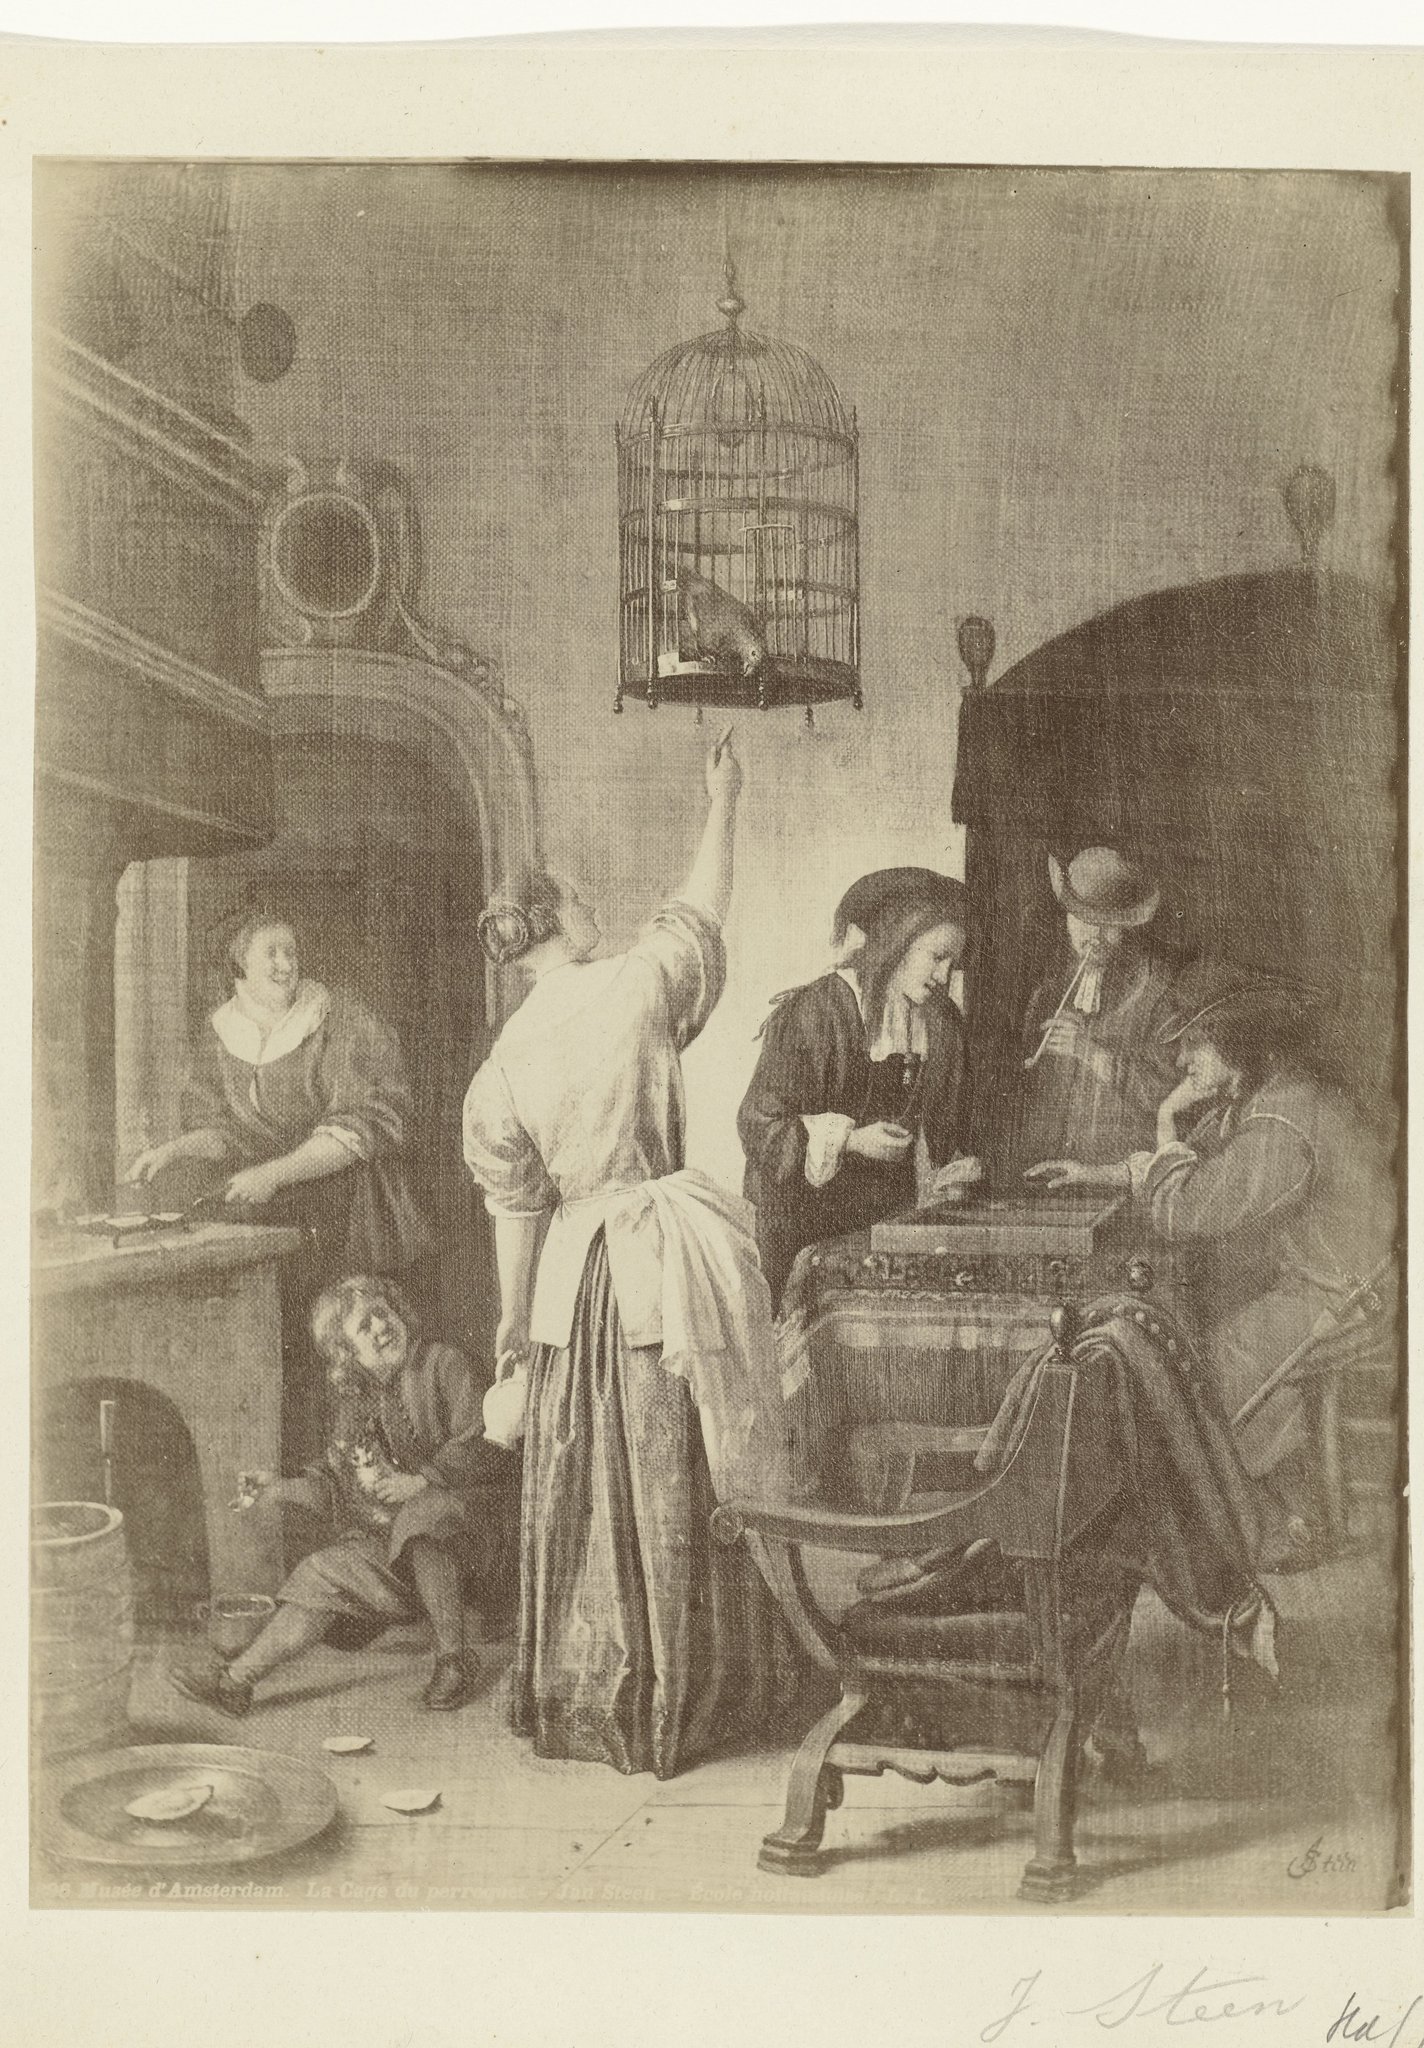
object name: reproduction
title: Fotoreproductie van het schilderij De papegaaiekooi van Jan Steen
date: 1867-1880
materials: cardboard, paper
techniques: albumen print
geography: amsterdam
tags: ornamental birds: parrot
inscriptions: inscription: ‘96 Musée d'Amsterdam. La Cage du perroquet. - Jan Steen. - Ecole hollandaise. L.L.’, inscription: ‘J. Steen/ Hdf 716/ 2245’